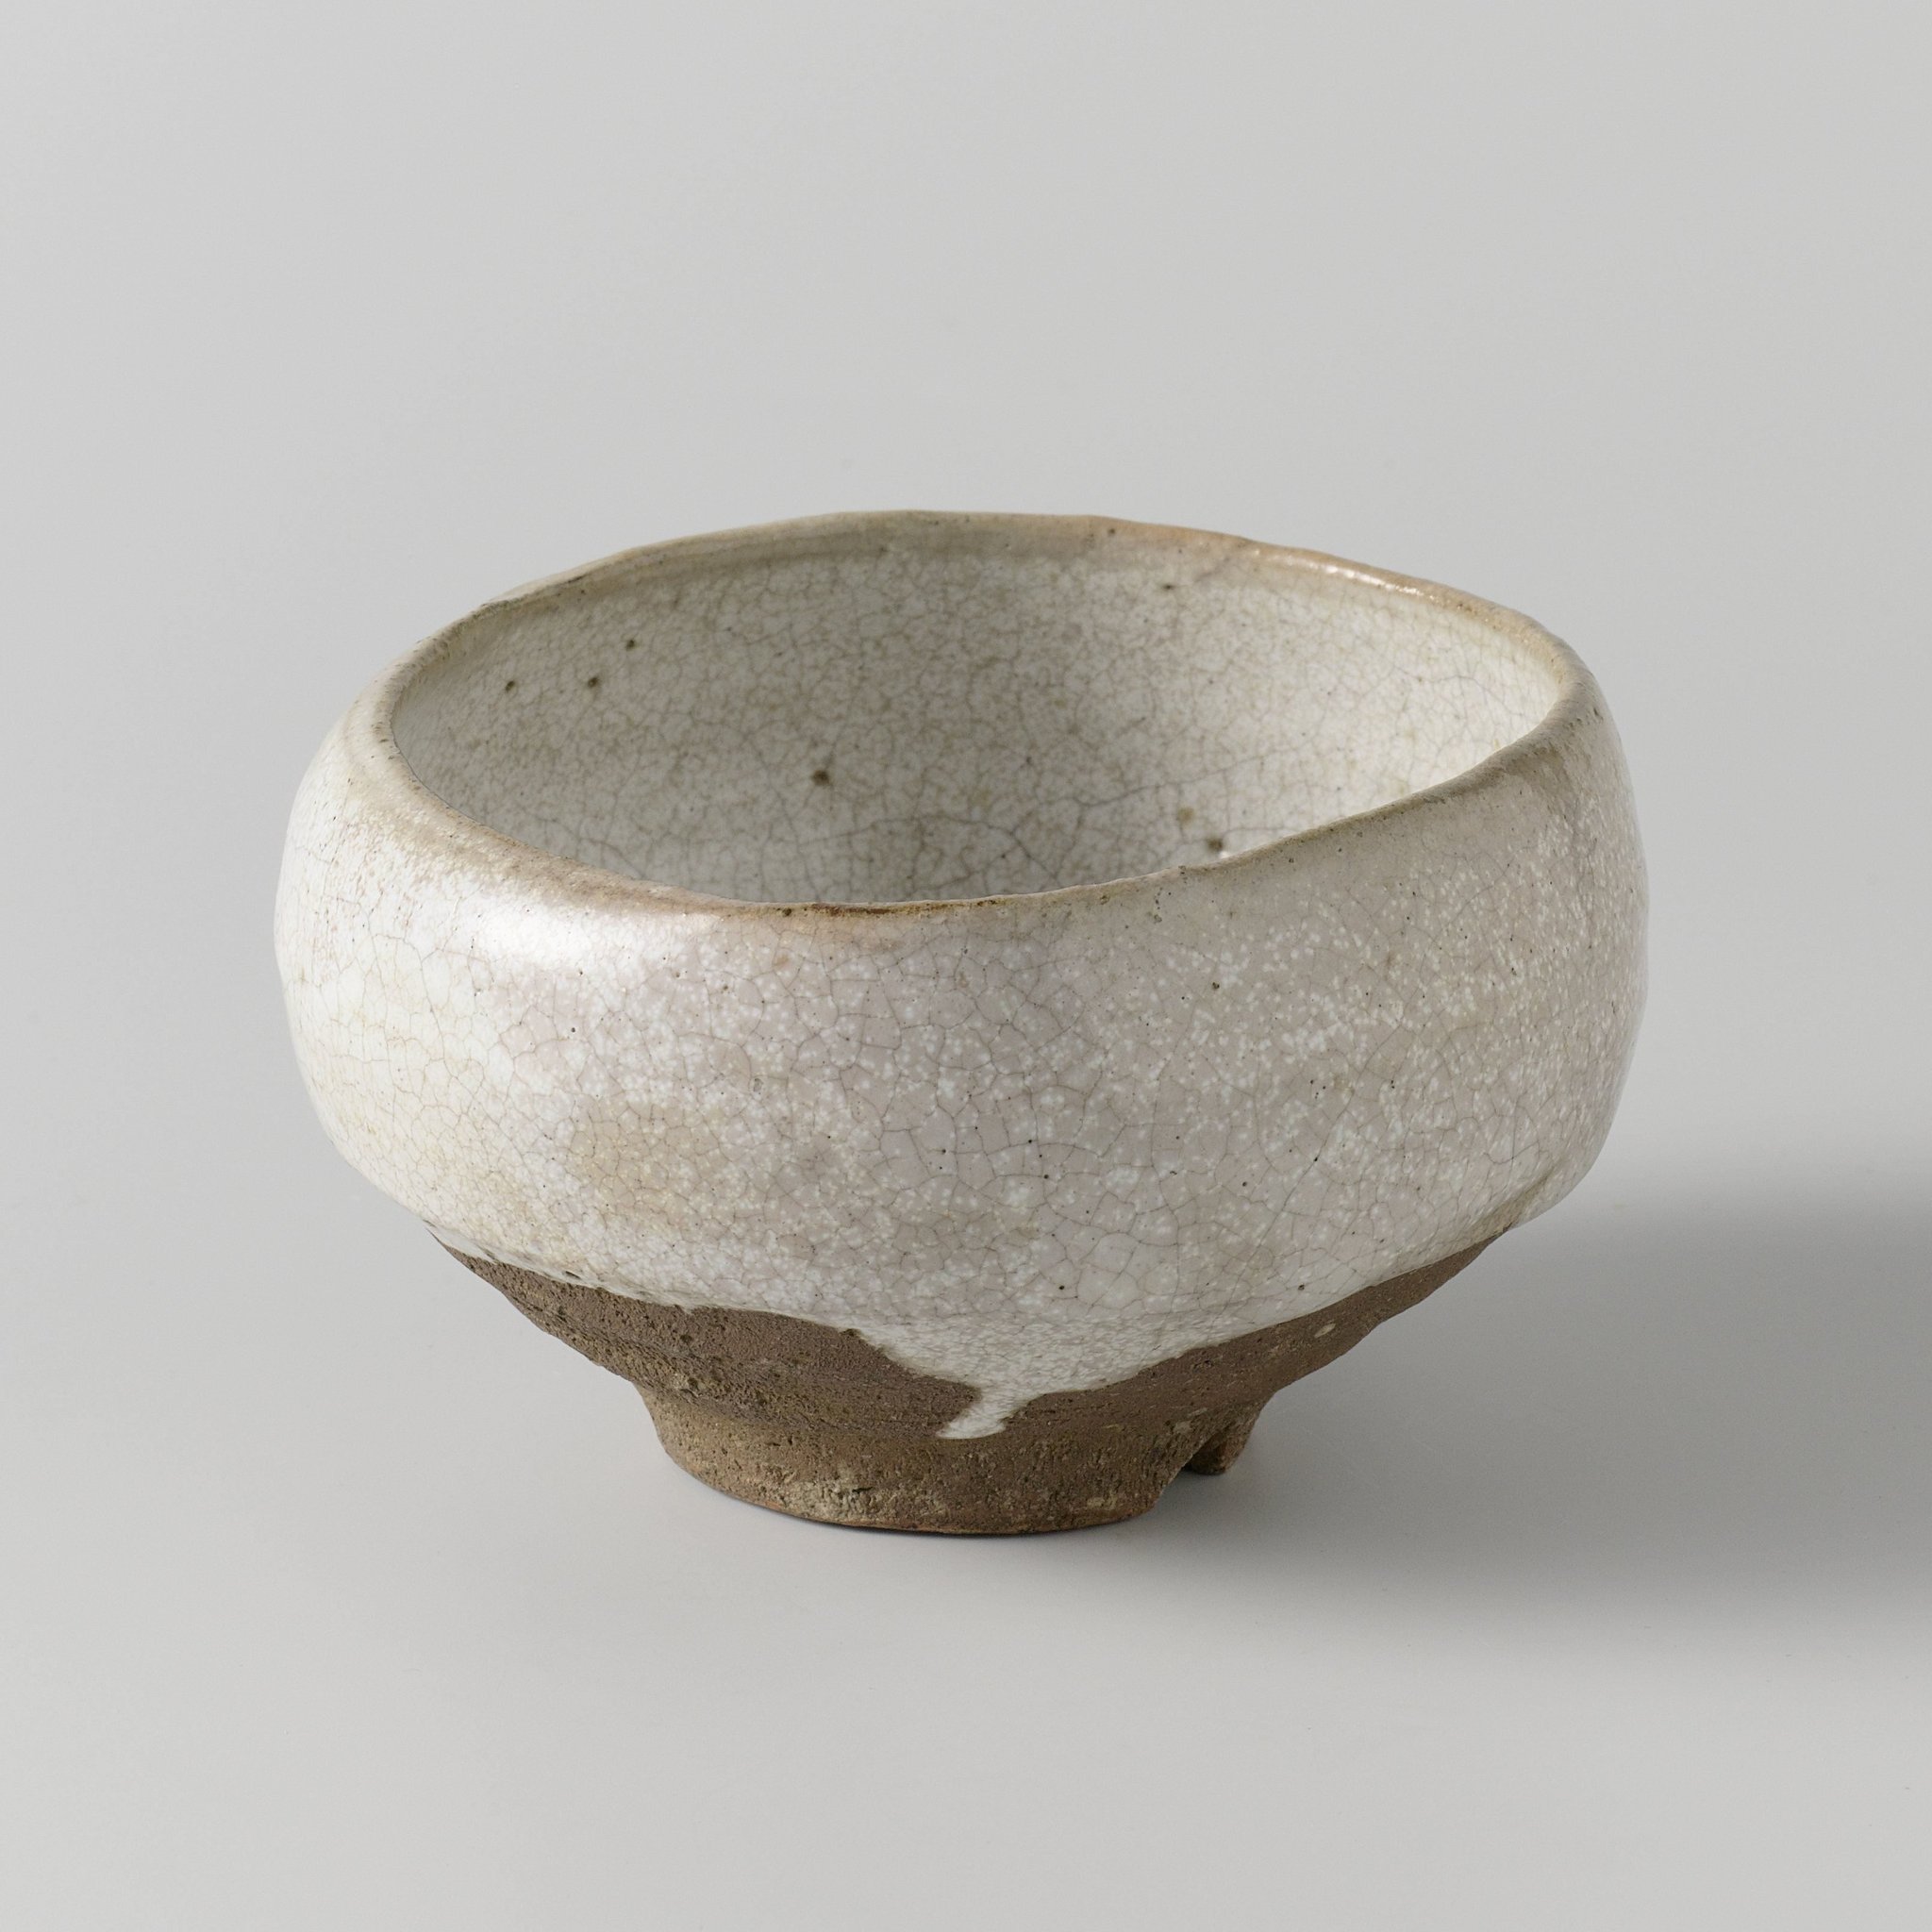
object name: tea bowl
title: Tea bowl with a grey glaze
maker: Anonymous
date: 1700-1799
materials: glaze, stoneware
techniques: firing, turning, vitrification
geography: japan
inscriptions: label: ‘W639’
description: Theekom van steengoed, gedeeltelijk bedekt met een lichtgrijs glazuur (kohiki). Het onderste deel van de kom is ongeglazuurd. Een inkeping in de voetring. Oud label op de onderzijde met 'W639'. Hagi.